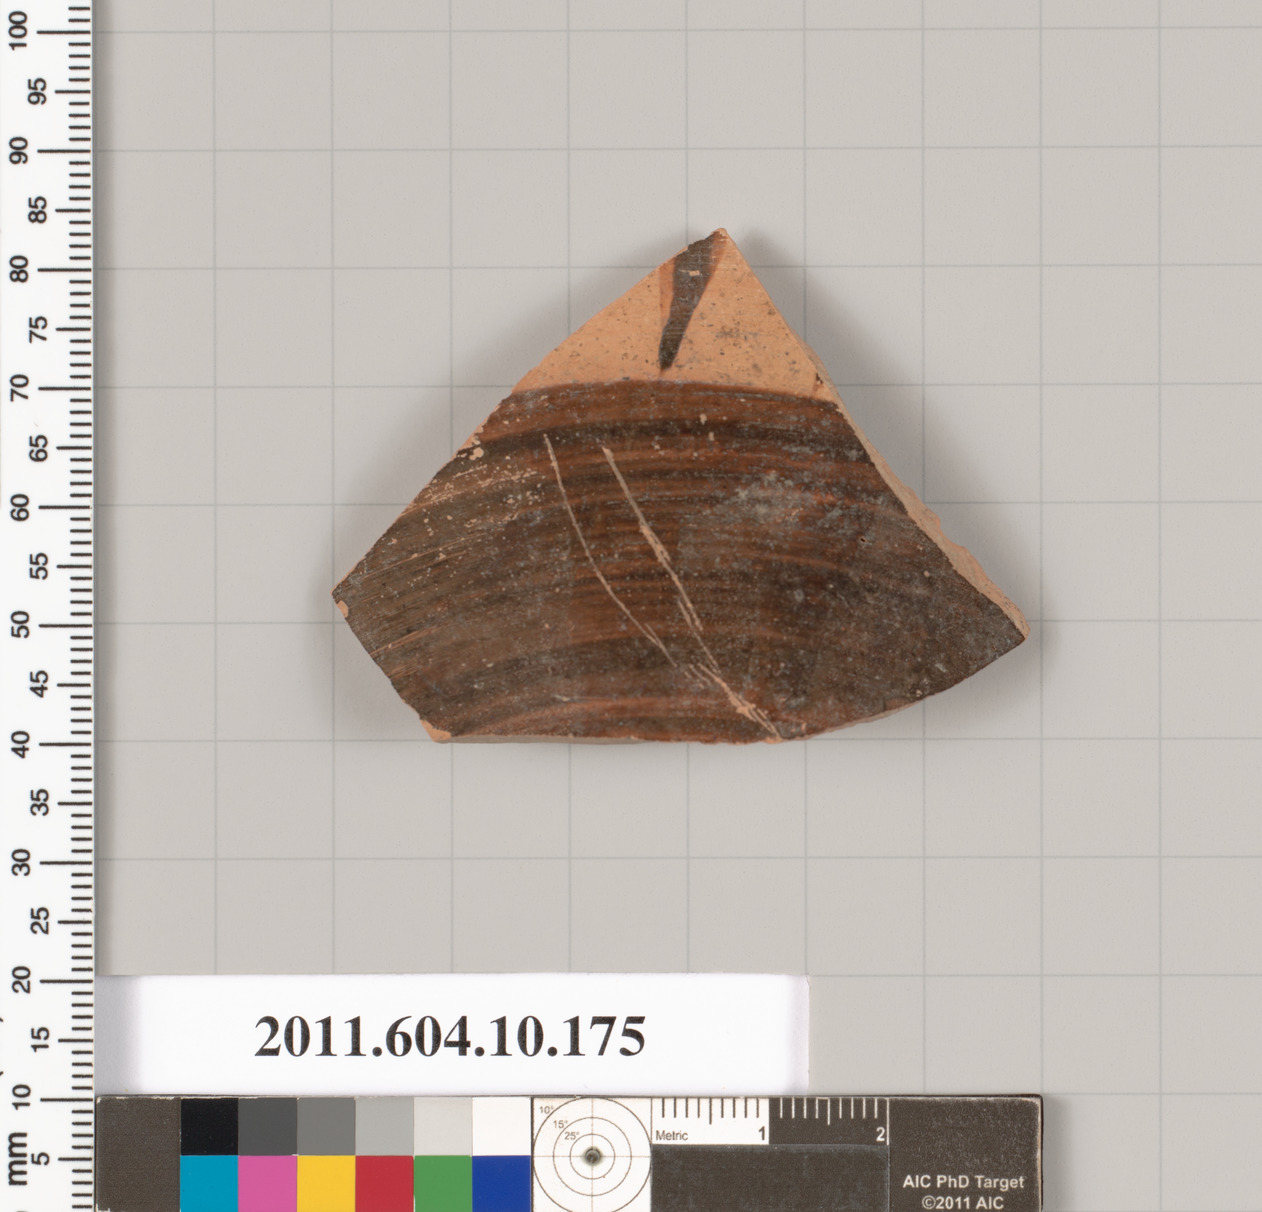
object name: skyphos fragment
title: Terracotta fragment of a skyphos (deep drinking cup)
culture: etruscan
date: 600-401 BCE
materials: terracotta